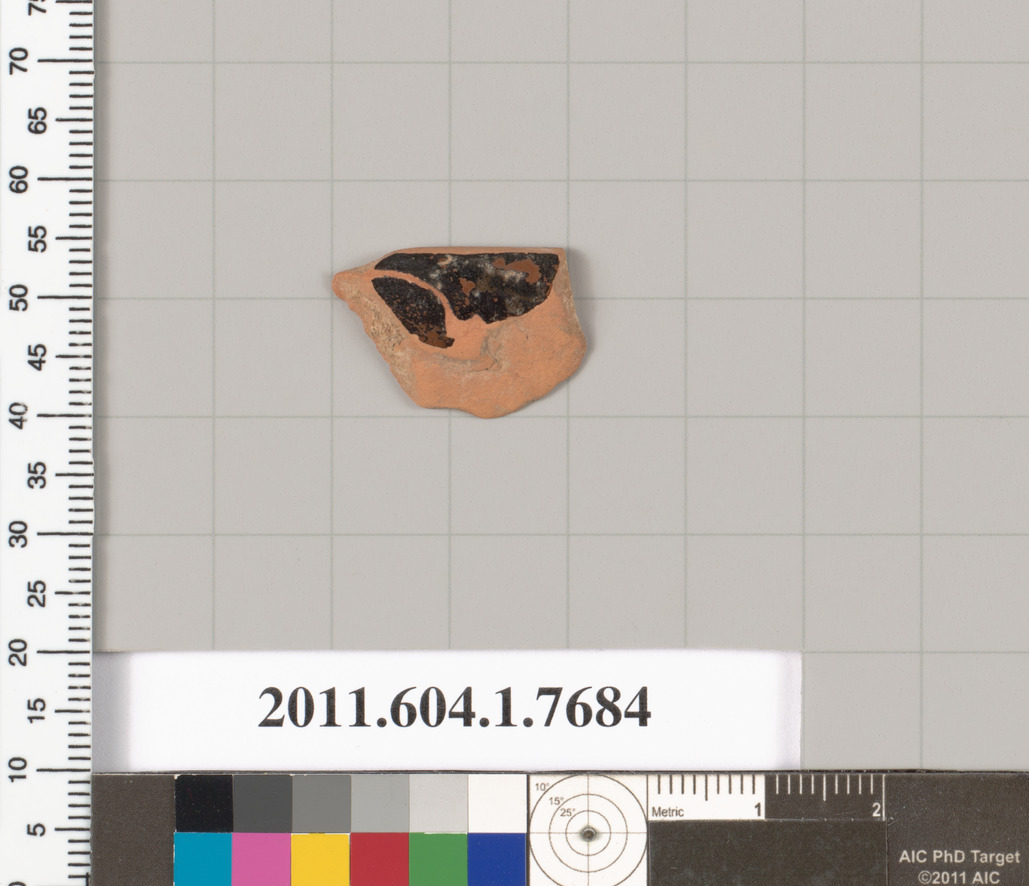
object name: kylix fragment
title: Terracotta rim fragment of a kylix (drinking cup)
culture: greek, attic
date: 460-450 BCE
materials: terracotta